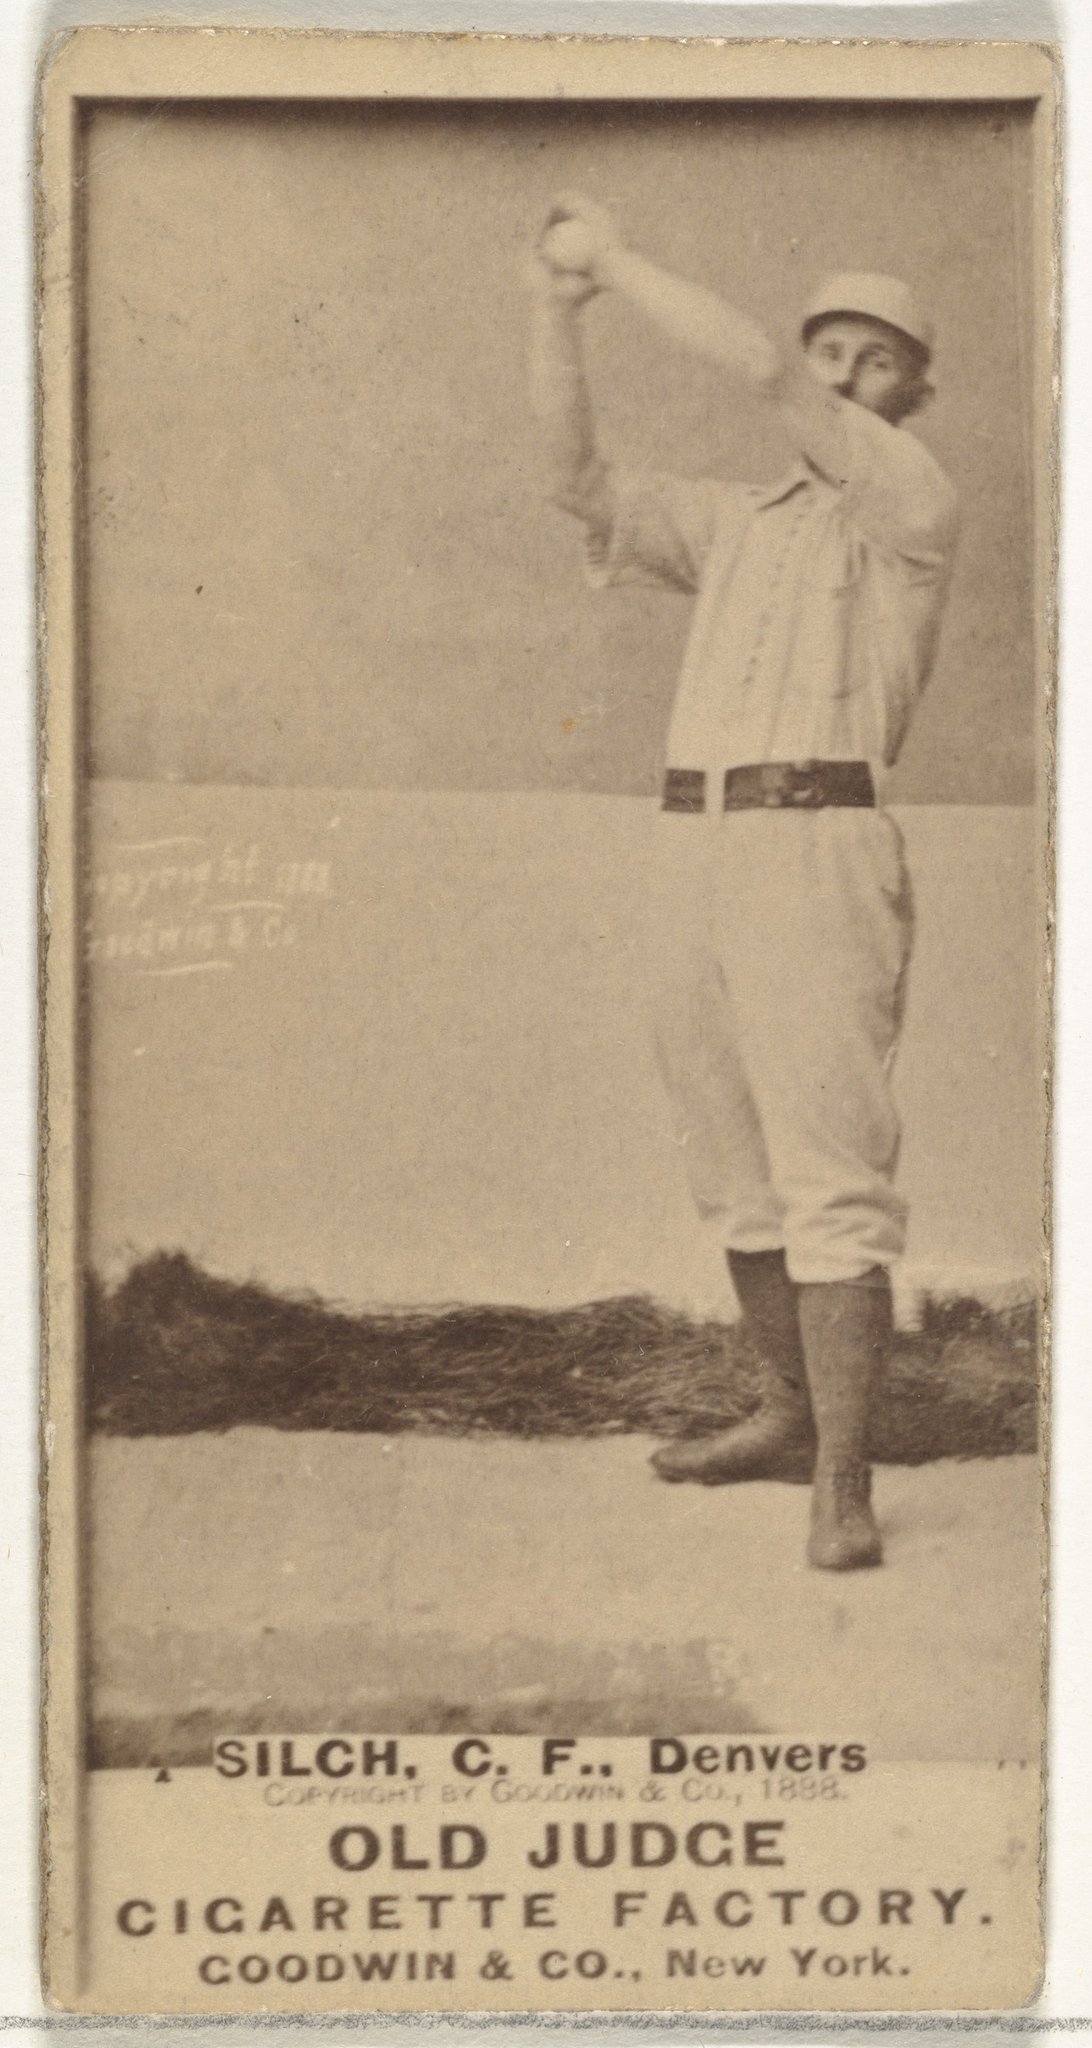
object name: baseball card, photograph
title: Ed "Baldy" Silch, Center Field, Denver, from the Old Judge series (N172) for Old Judge Cigarettes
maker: goodwin & company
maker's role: publisher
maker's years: 1850-1950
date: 1888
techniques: albumen silver print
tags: men,portraits,baseball,athletes